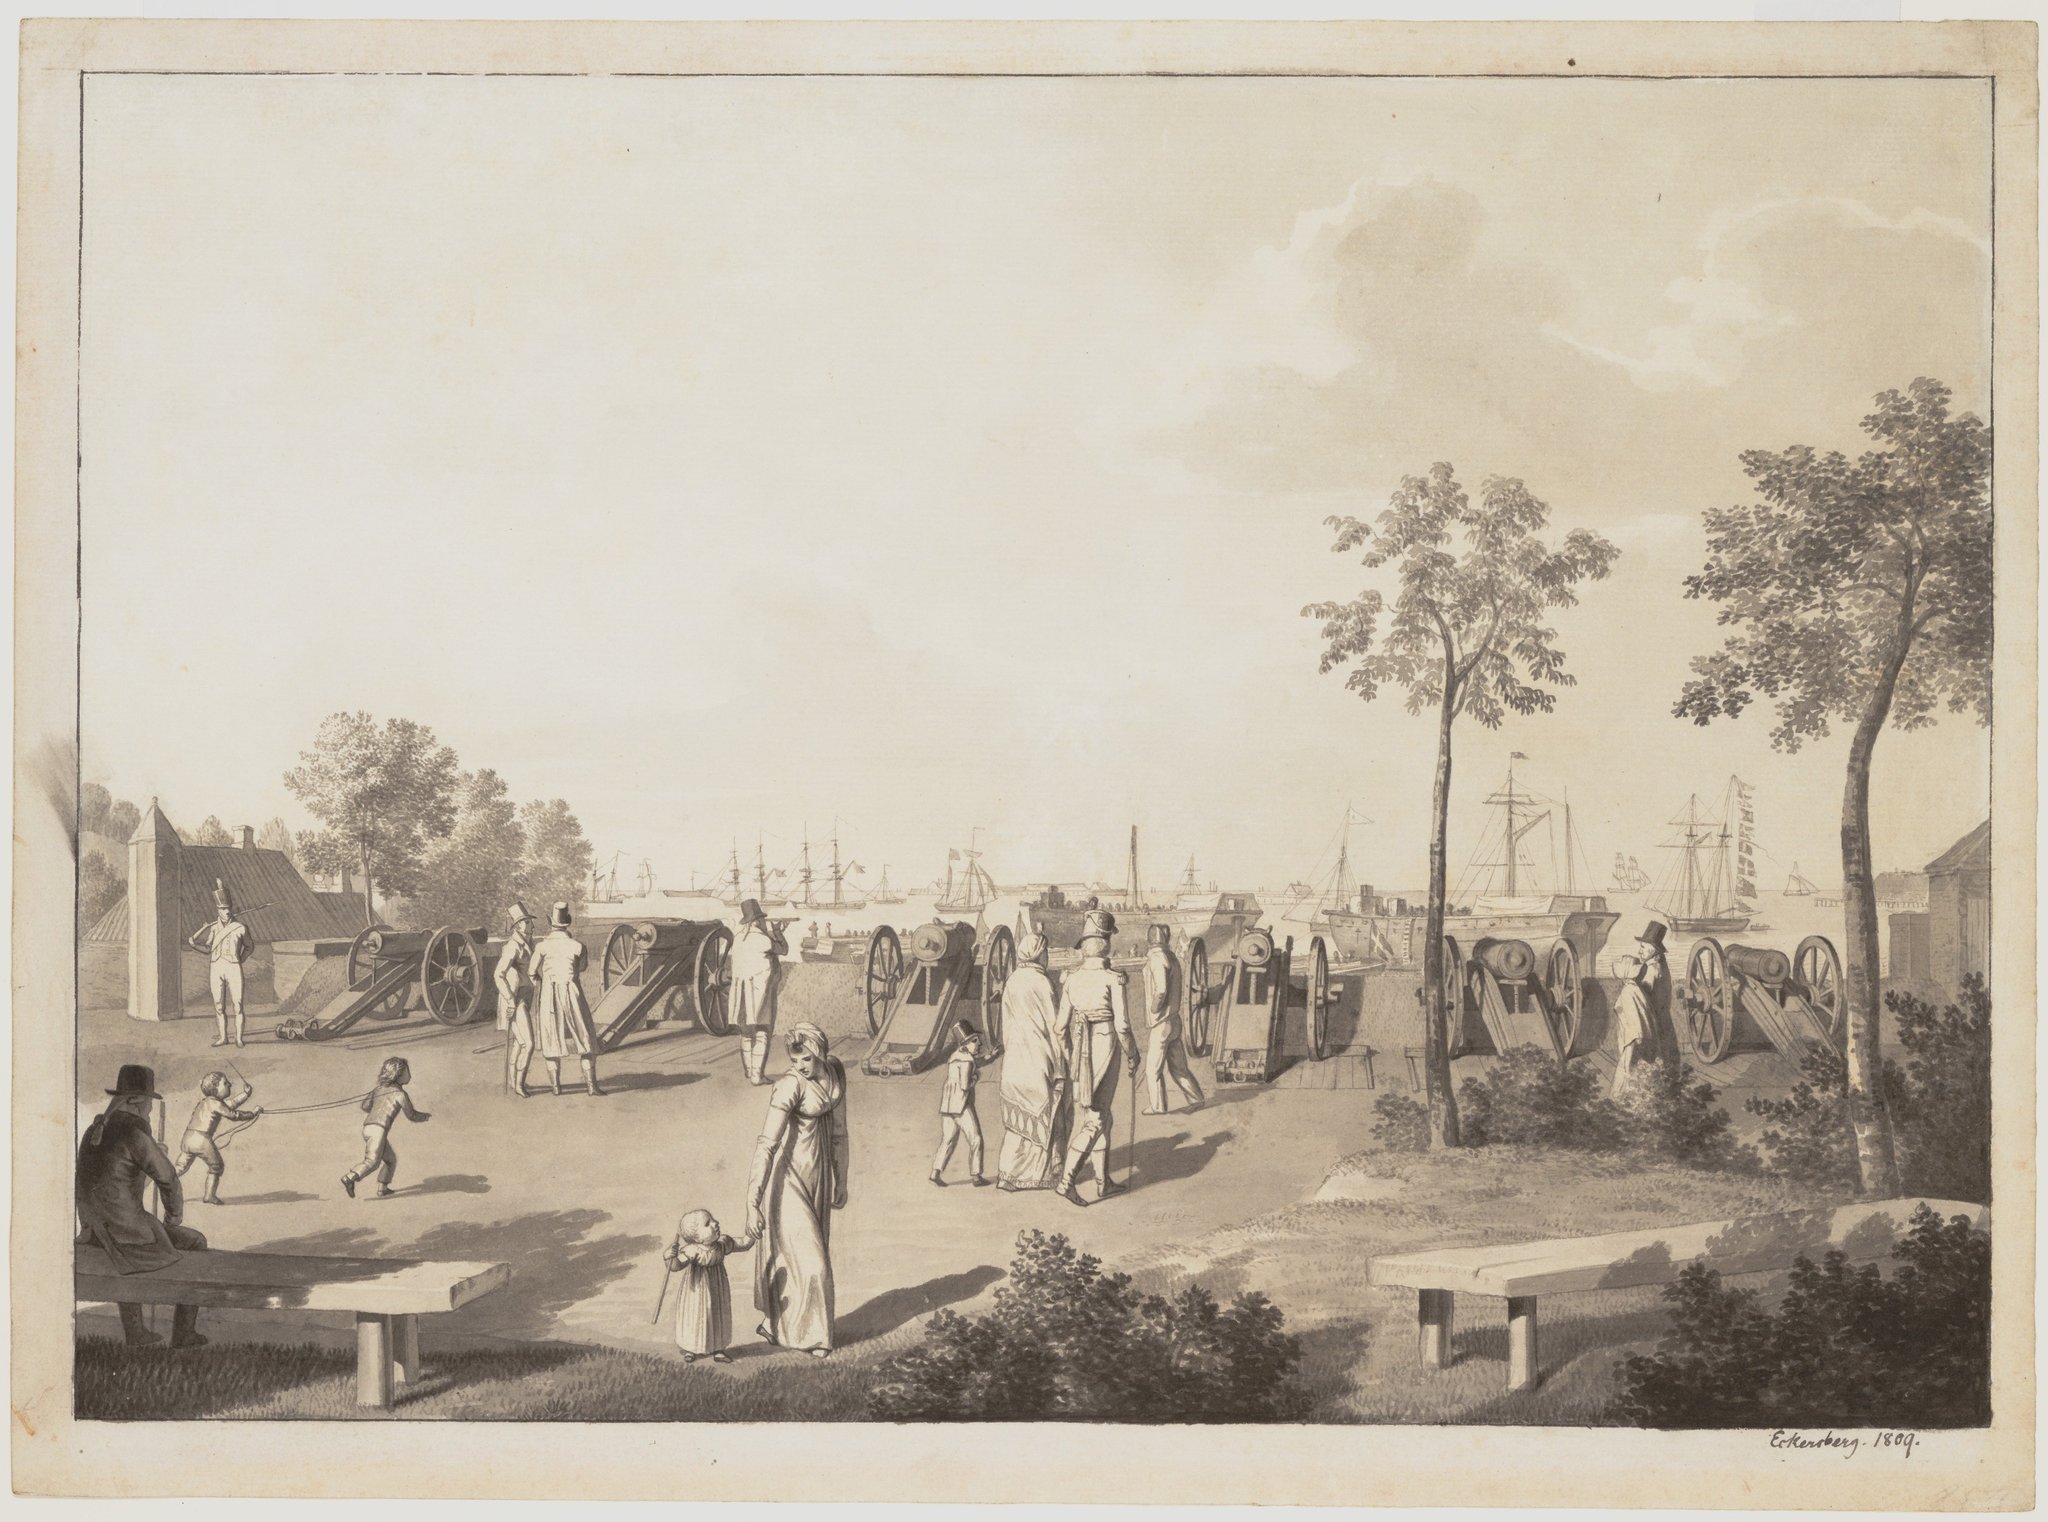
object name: drawing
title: The Harbor of Copenhagen from the Esplanade between Langelinie Park and Toldboden or the Customs House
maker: christoffer wilhelm eckersberg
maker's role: artist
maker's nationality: danish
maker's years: 1783-1853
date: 1809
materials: graphite, ink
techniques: brush, pen, wash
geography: denmark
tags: cannons,men,women,ships